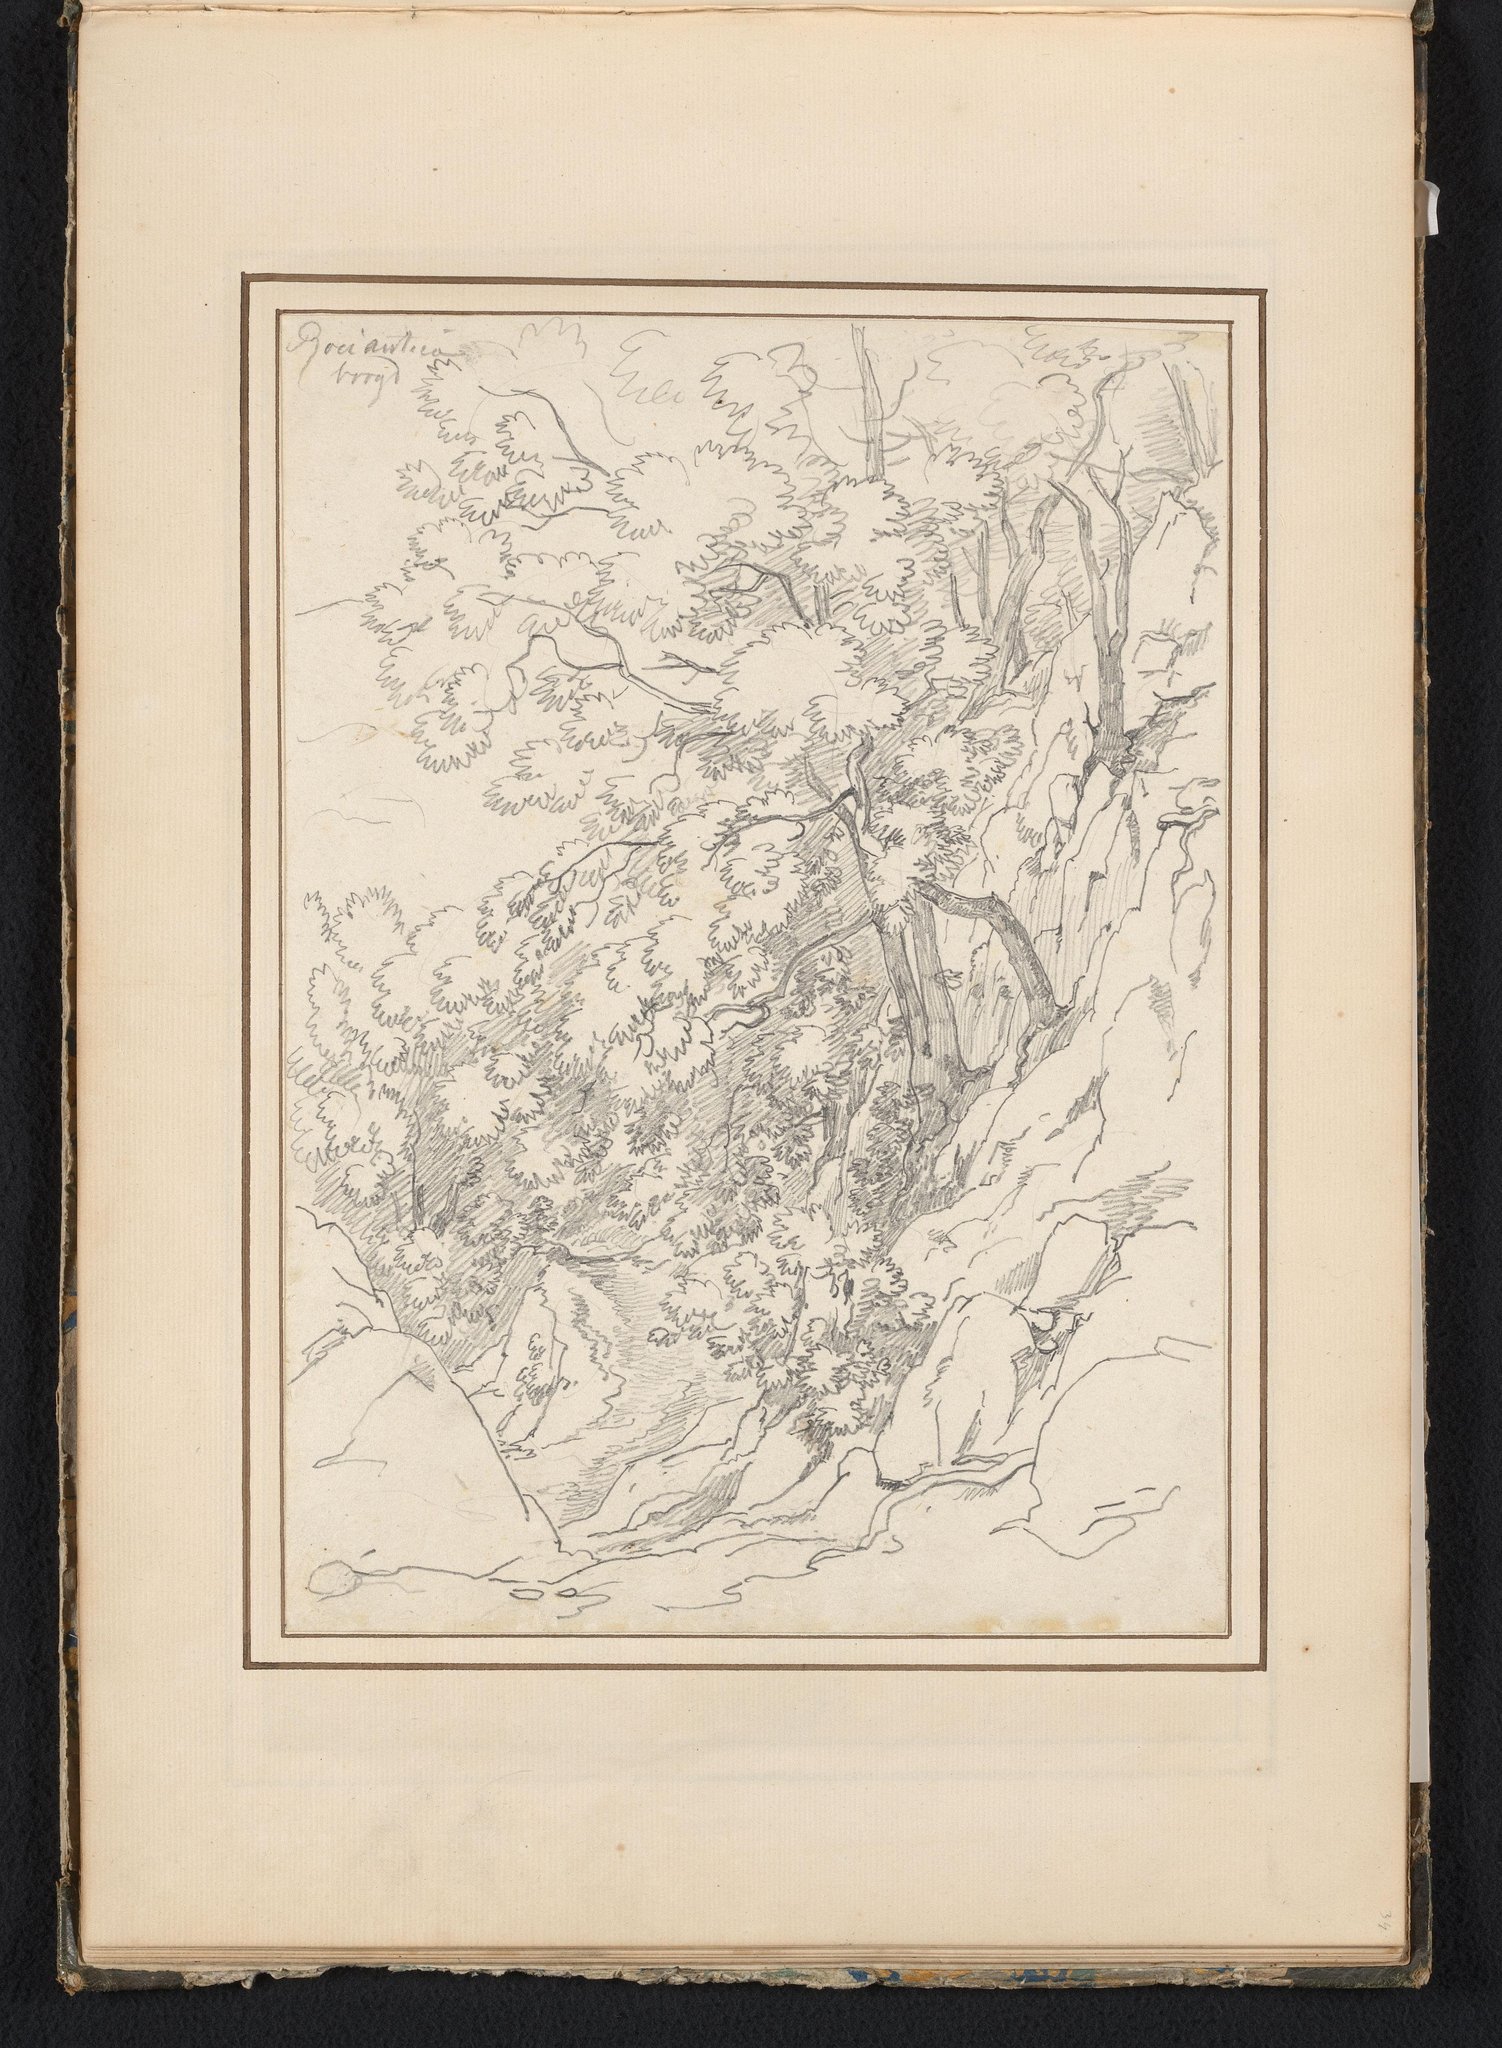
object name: album leaf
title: Landschap met rotsen en bomen te Roccantica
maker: hendrik voogd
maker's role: draughtsman, painter, print maker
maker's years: 1768-1839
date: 1788-1839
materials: paper, pencil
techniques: pasting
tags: trees, rock-formations, roccantica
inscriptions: inscription: ‘Rocc'antica’